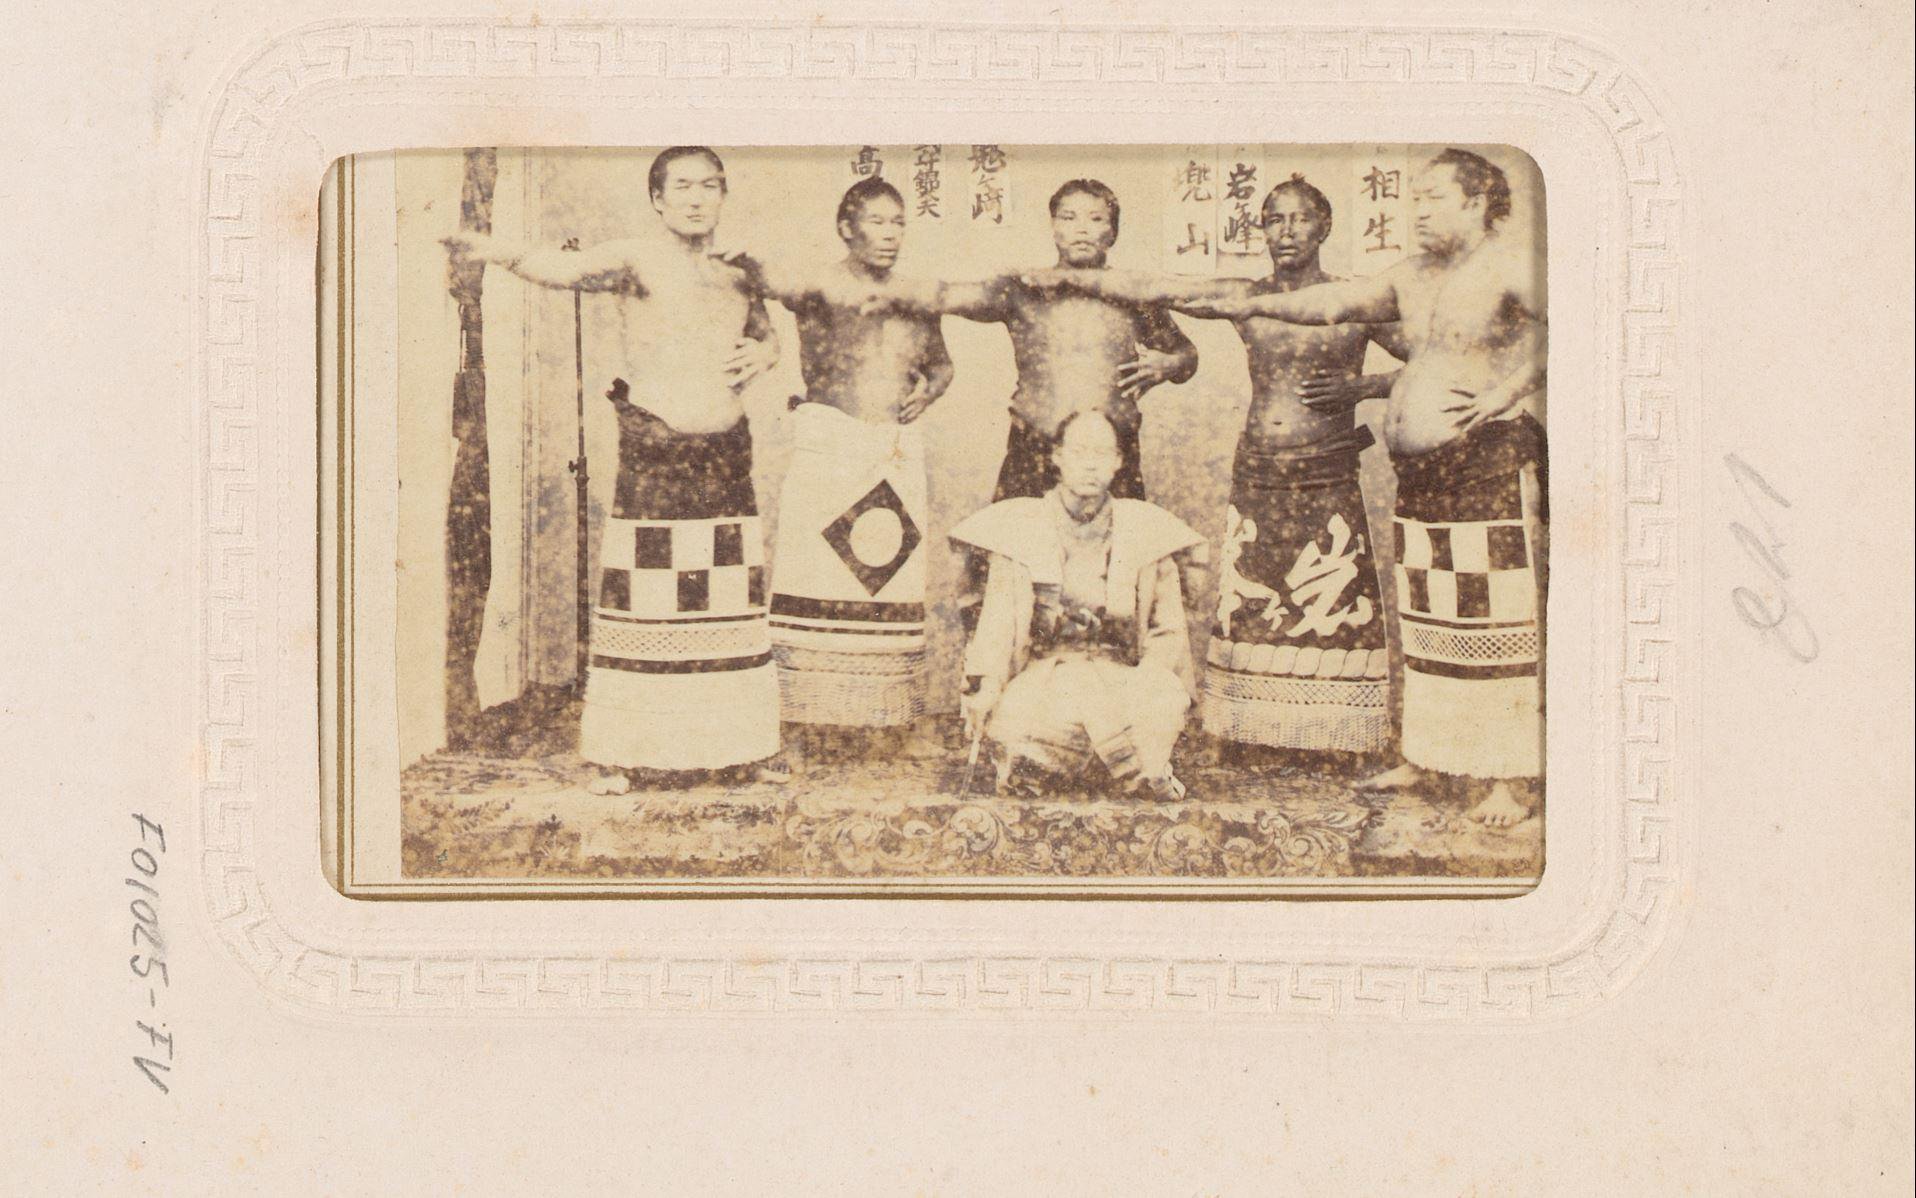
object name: carte de visite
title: Groepsportret van Japanse worstelaars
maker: Anonymous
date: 1850-1880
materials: cardboard, photographic support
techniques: albumen print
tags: wrestling (sport), anonymous historical persons portrayed in a group, in a group-portrait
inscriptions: number: ‘178’